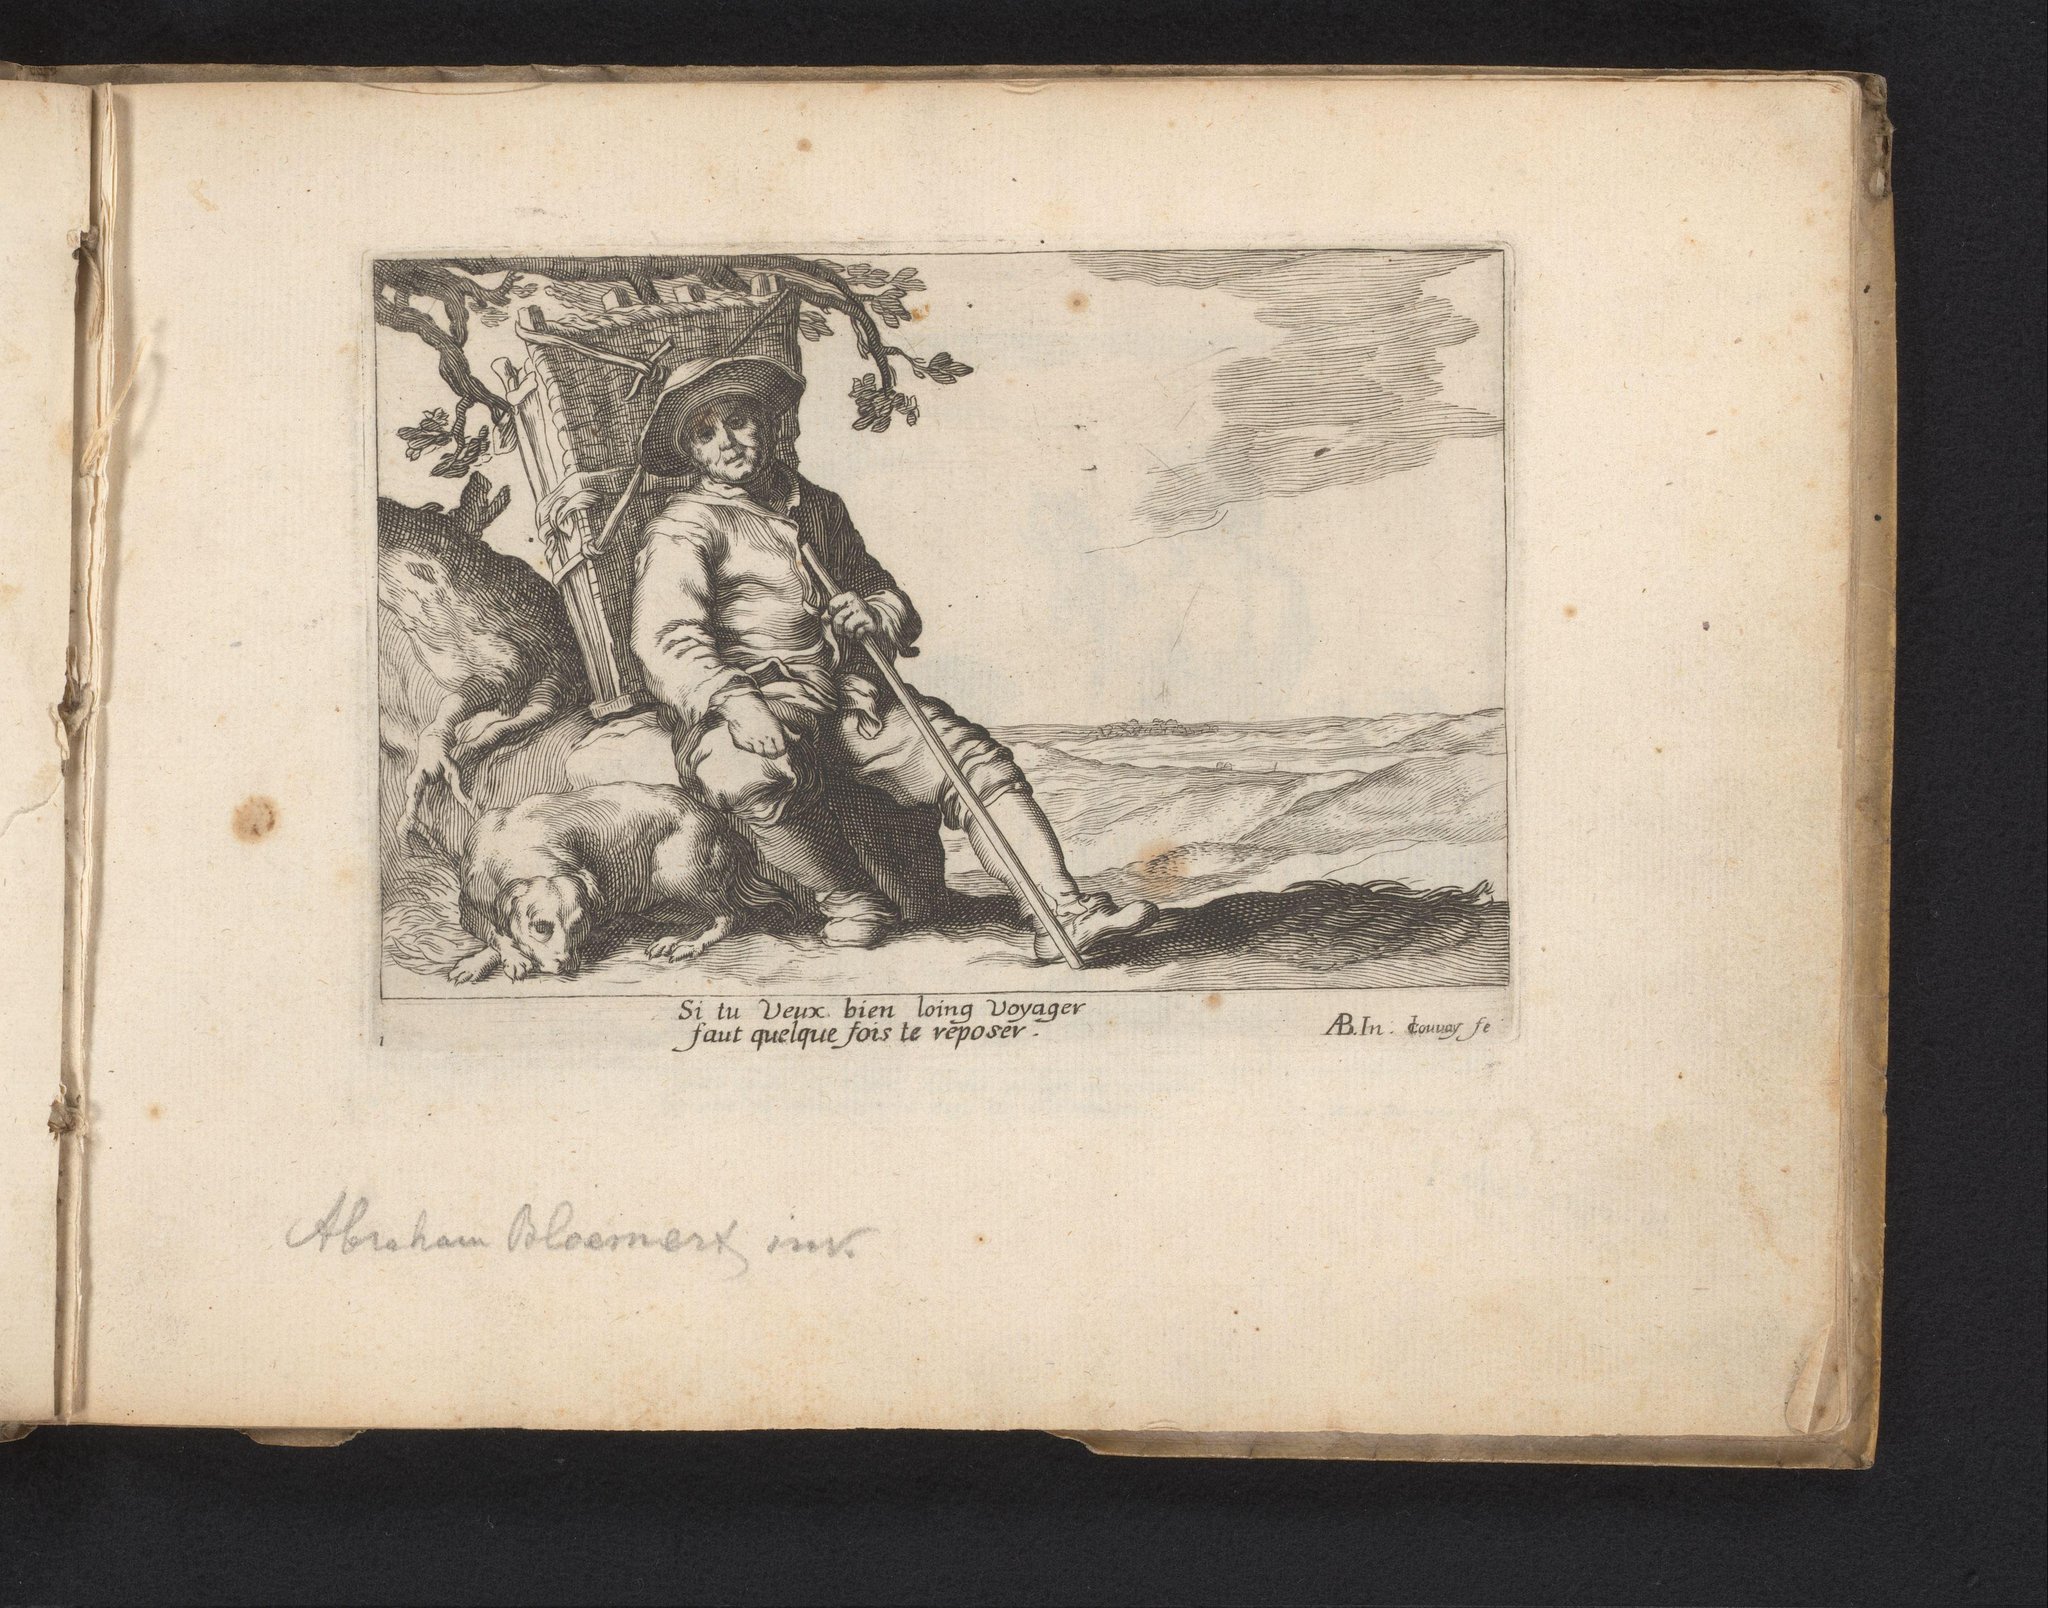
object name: album leaf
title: Reiziger met een mand op zijn rug en een slapende hond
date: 1632-1675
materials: paper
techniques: etching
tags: (traveller) resting in the open air, wandering or travelling merchant, dog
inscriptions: collector's mark: ‘Bibliotheek/ Rijksmuseum/ Amsterdam’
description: Deze prent maakt deel uit van een album.